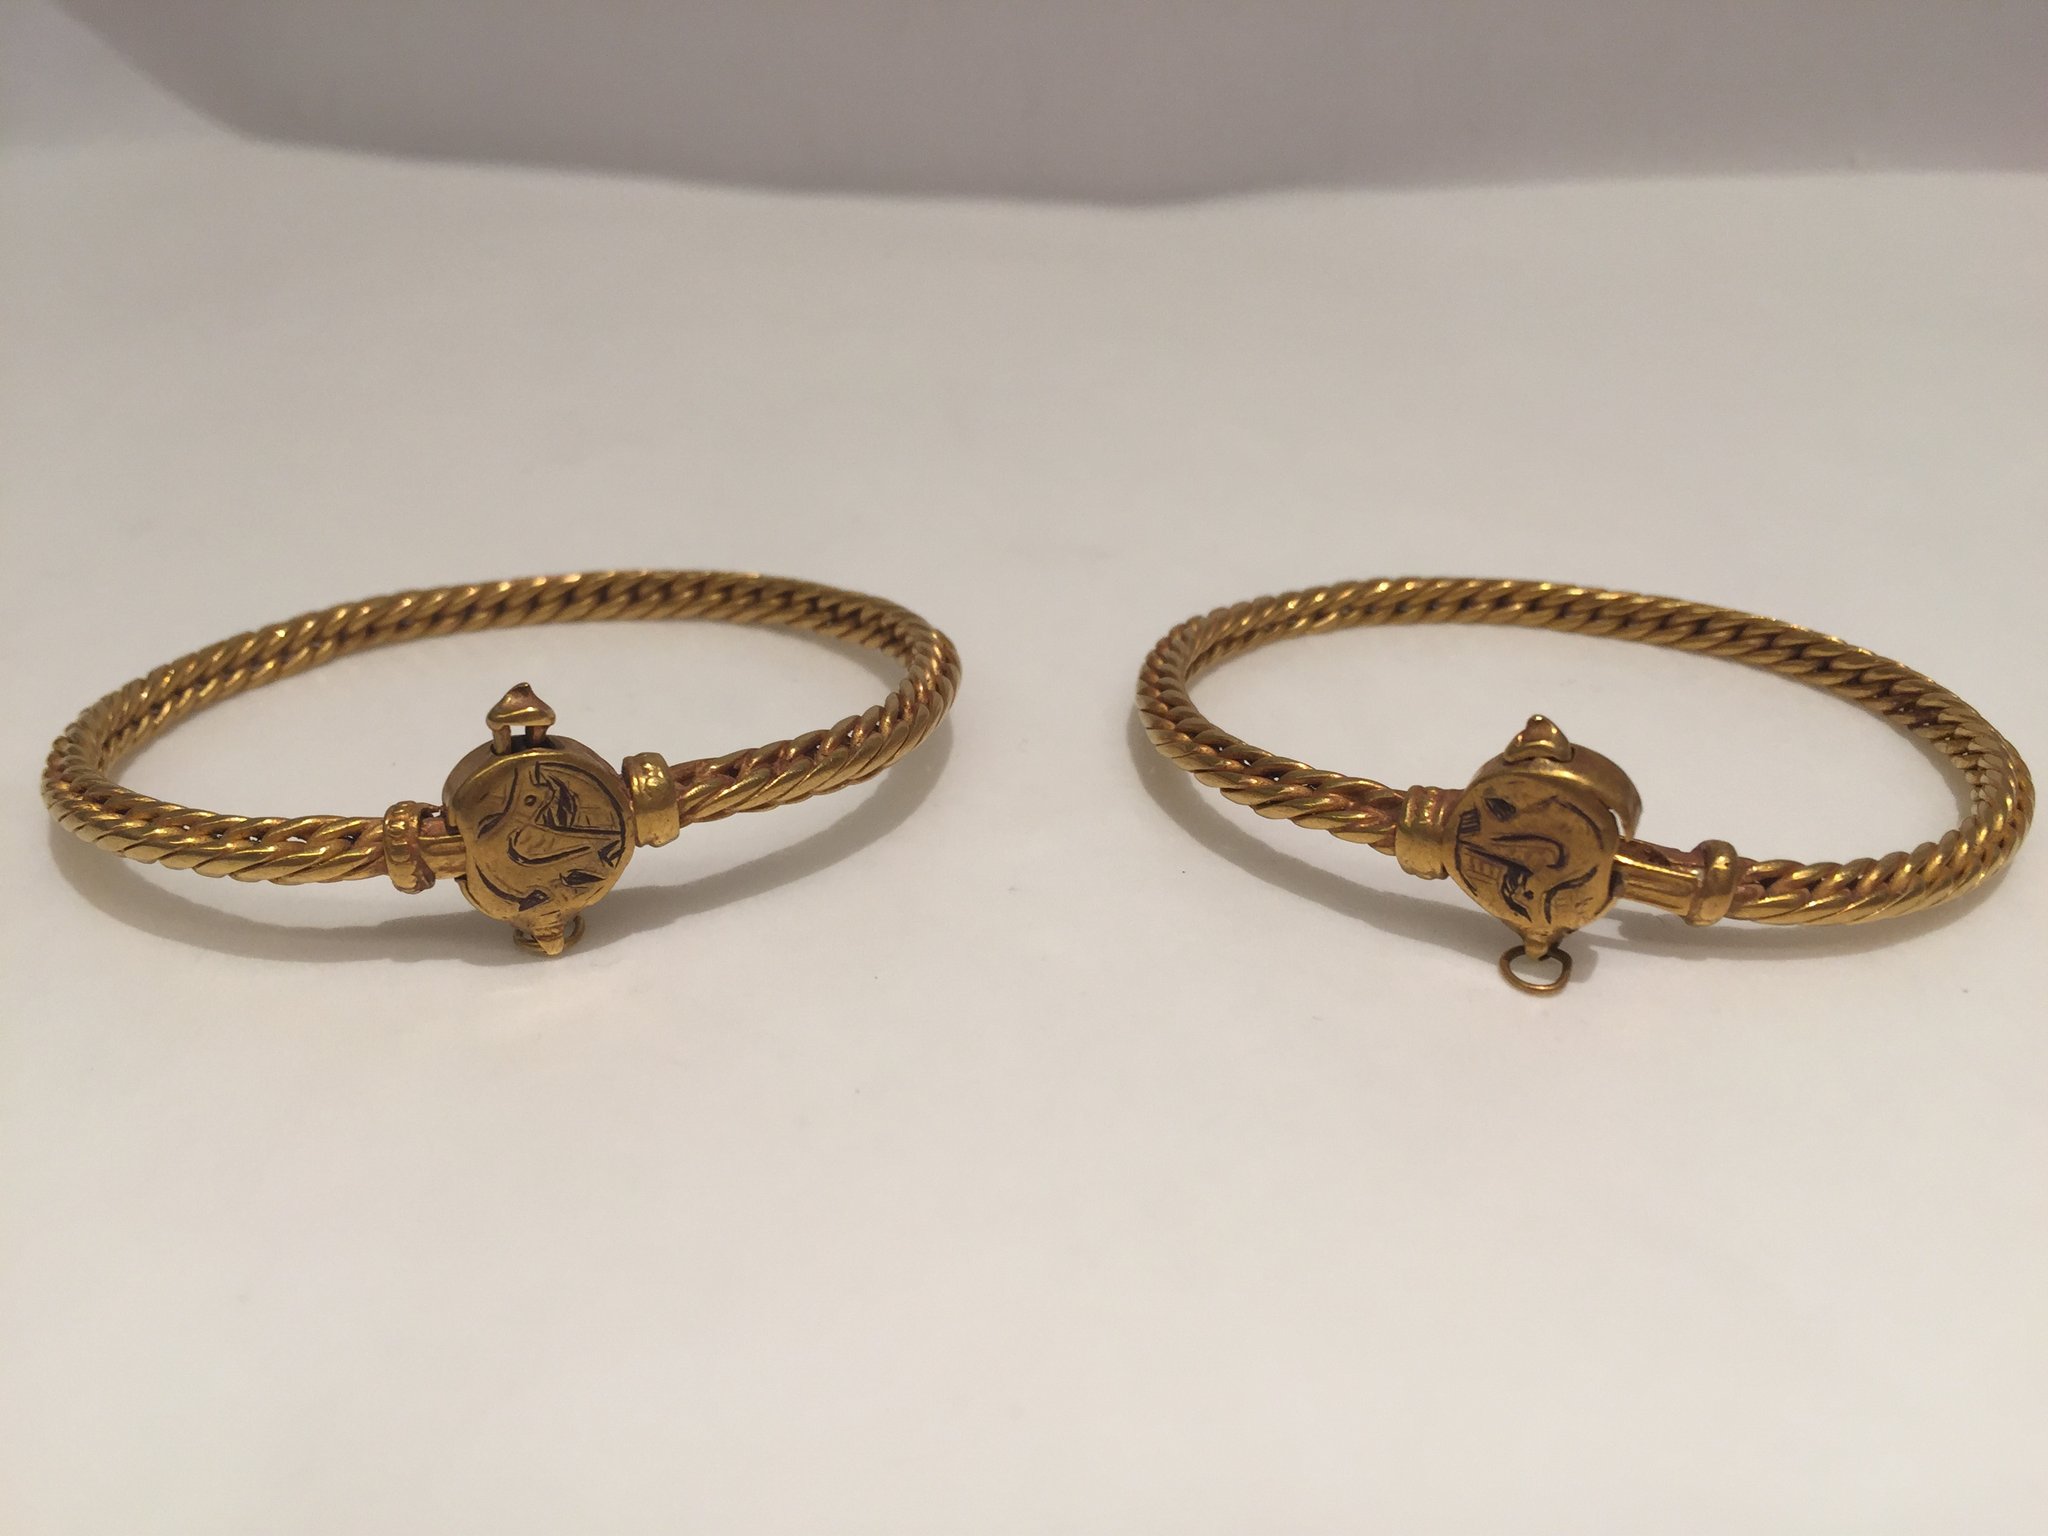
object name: bracelet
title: Bracelet, One of a Pair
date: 1001-1300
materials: gold, metal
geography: iran